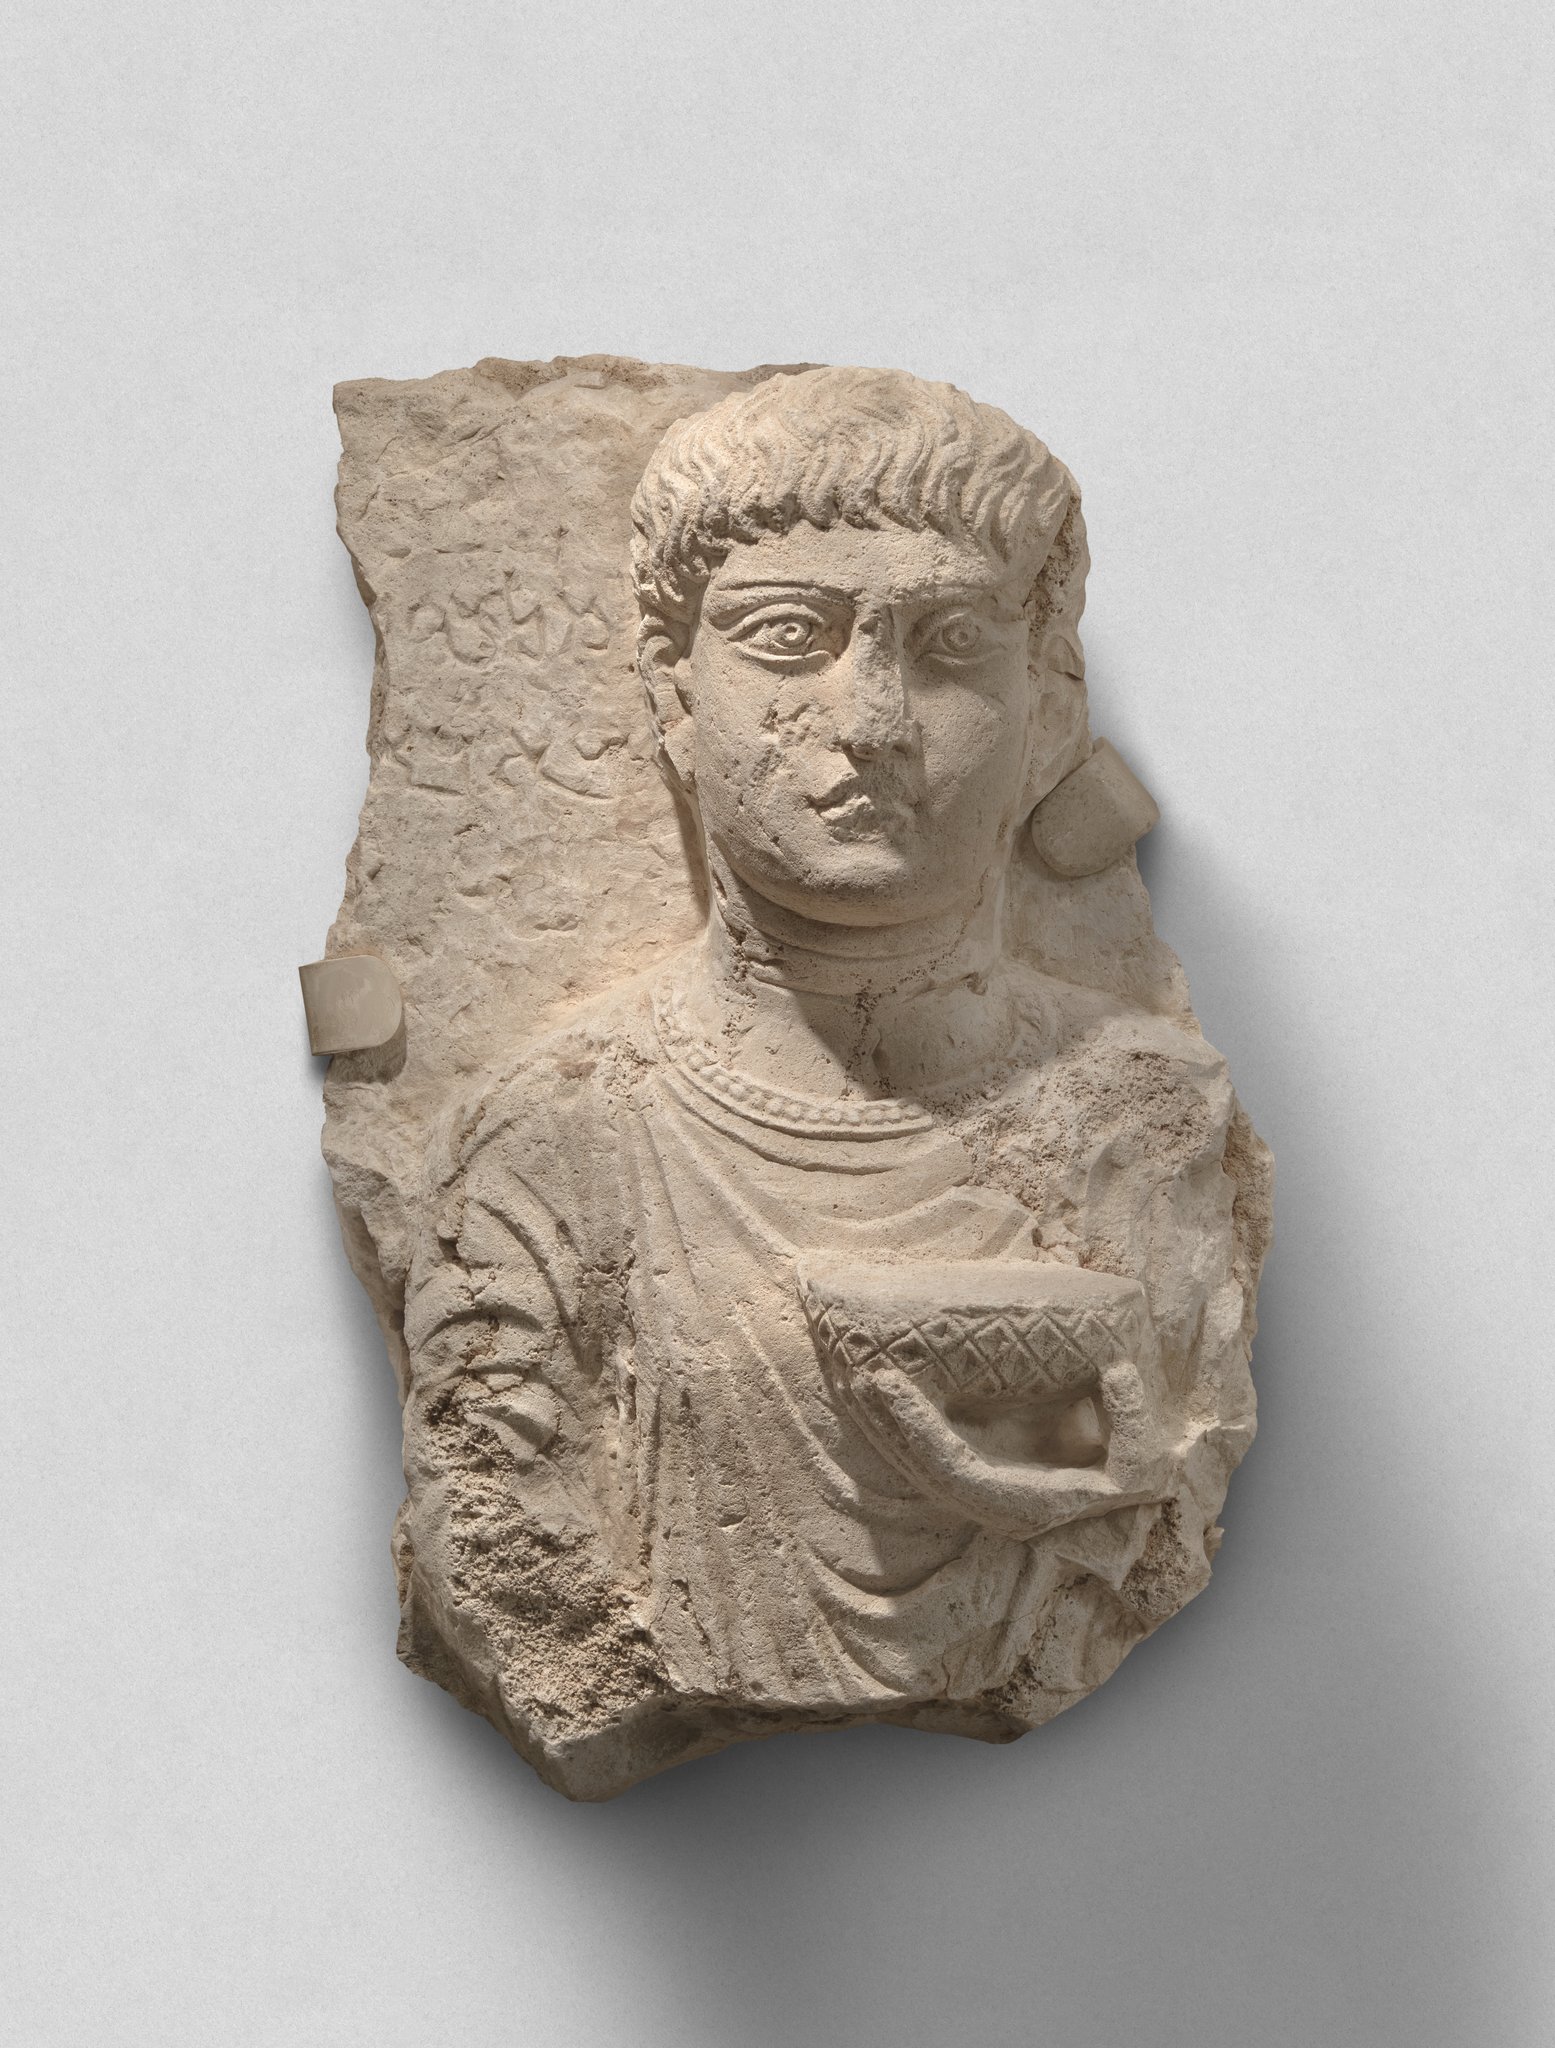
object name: funerary relief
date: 150-200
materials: limestone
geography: syria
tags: men